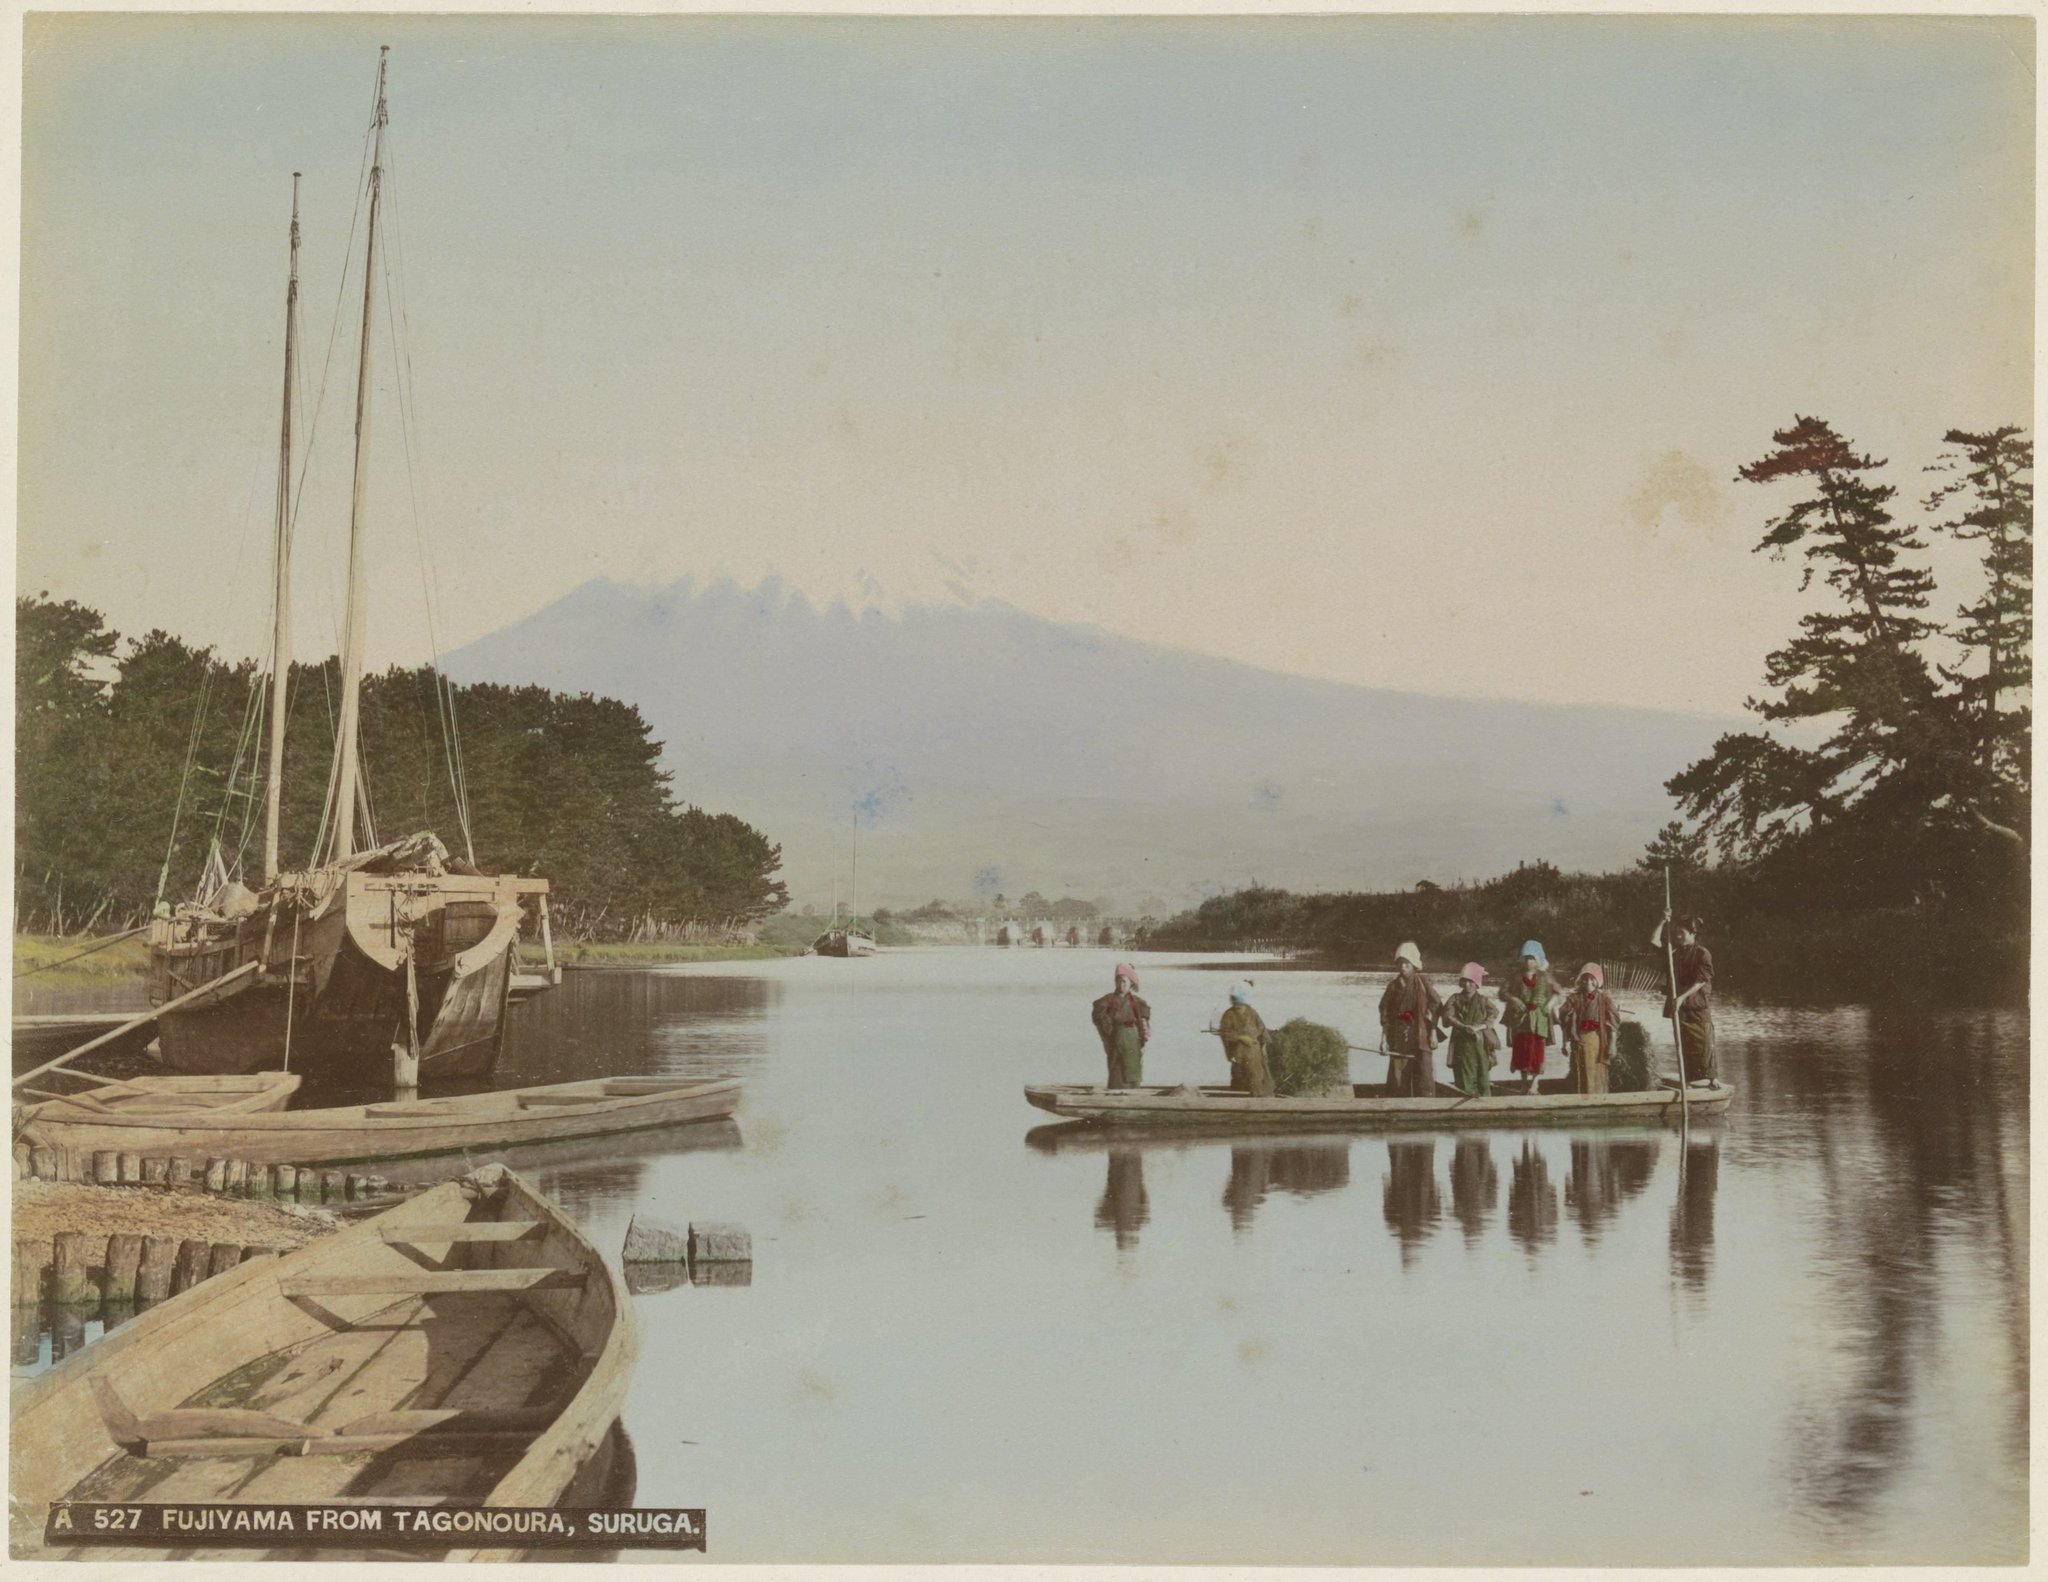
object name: photograph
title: Berg Fuji gezien over een water bij Tagonoura, met op de voorgrond mensen op een boot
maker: Anonymous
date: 1870-1900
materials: cardboard, paper, photographic support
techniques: albumen print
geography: japan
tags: mountain-top, peak (+ landscape with figures, staffage), poling, punting, japan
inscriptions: negative number: ‘A 527’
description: Onderdeel van Reisalbum met foto's van bezienswaardigheden in Japan.